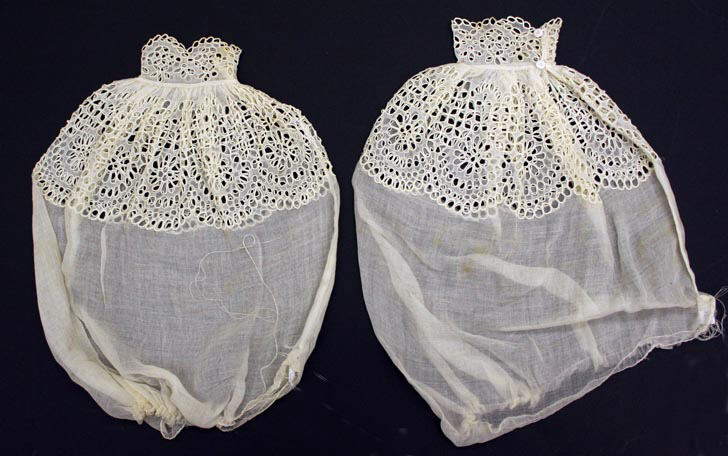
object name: undersleeves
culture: british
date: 1850-1859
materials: cotton